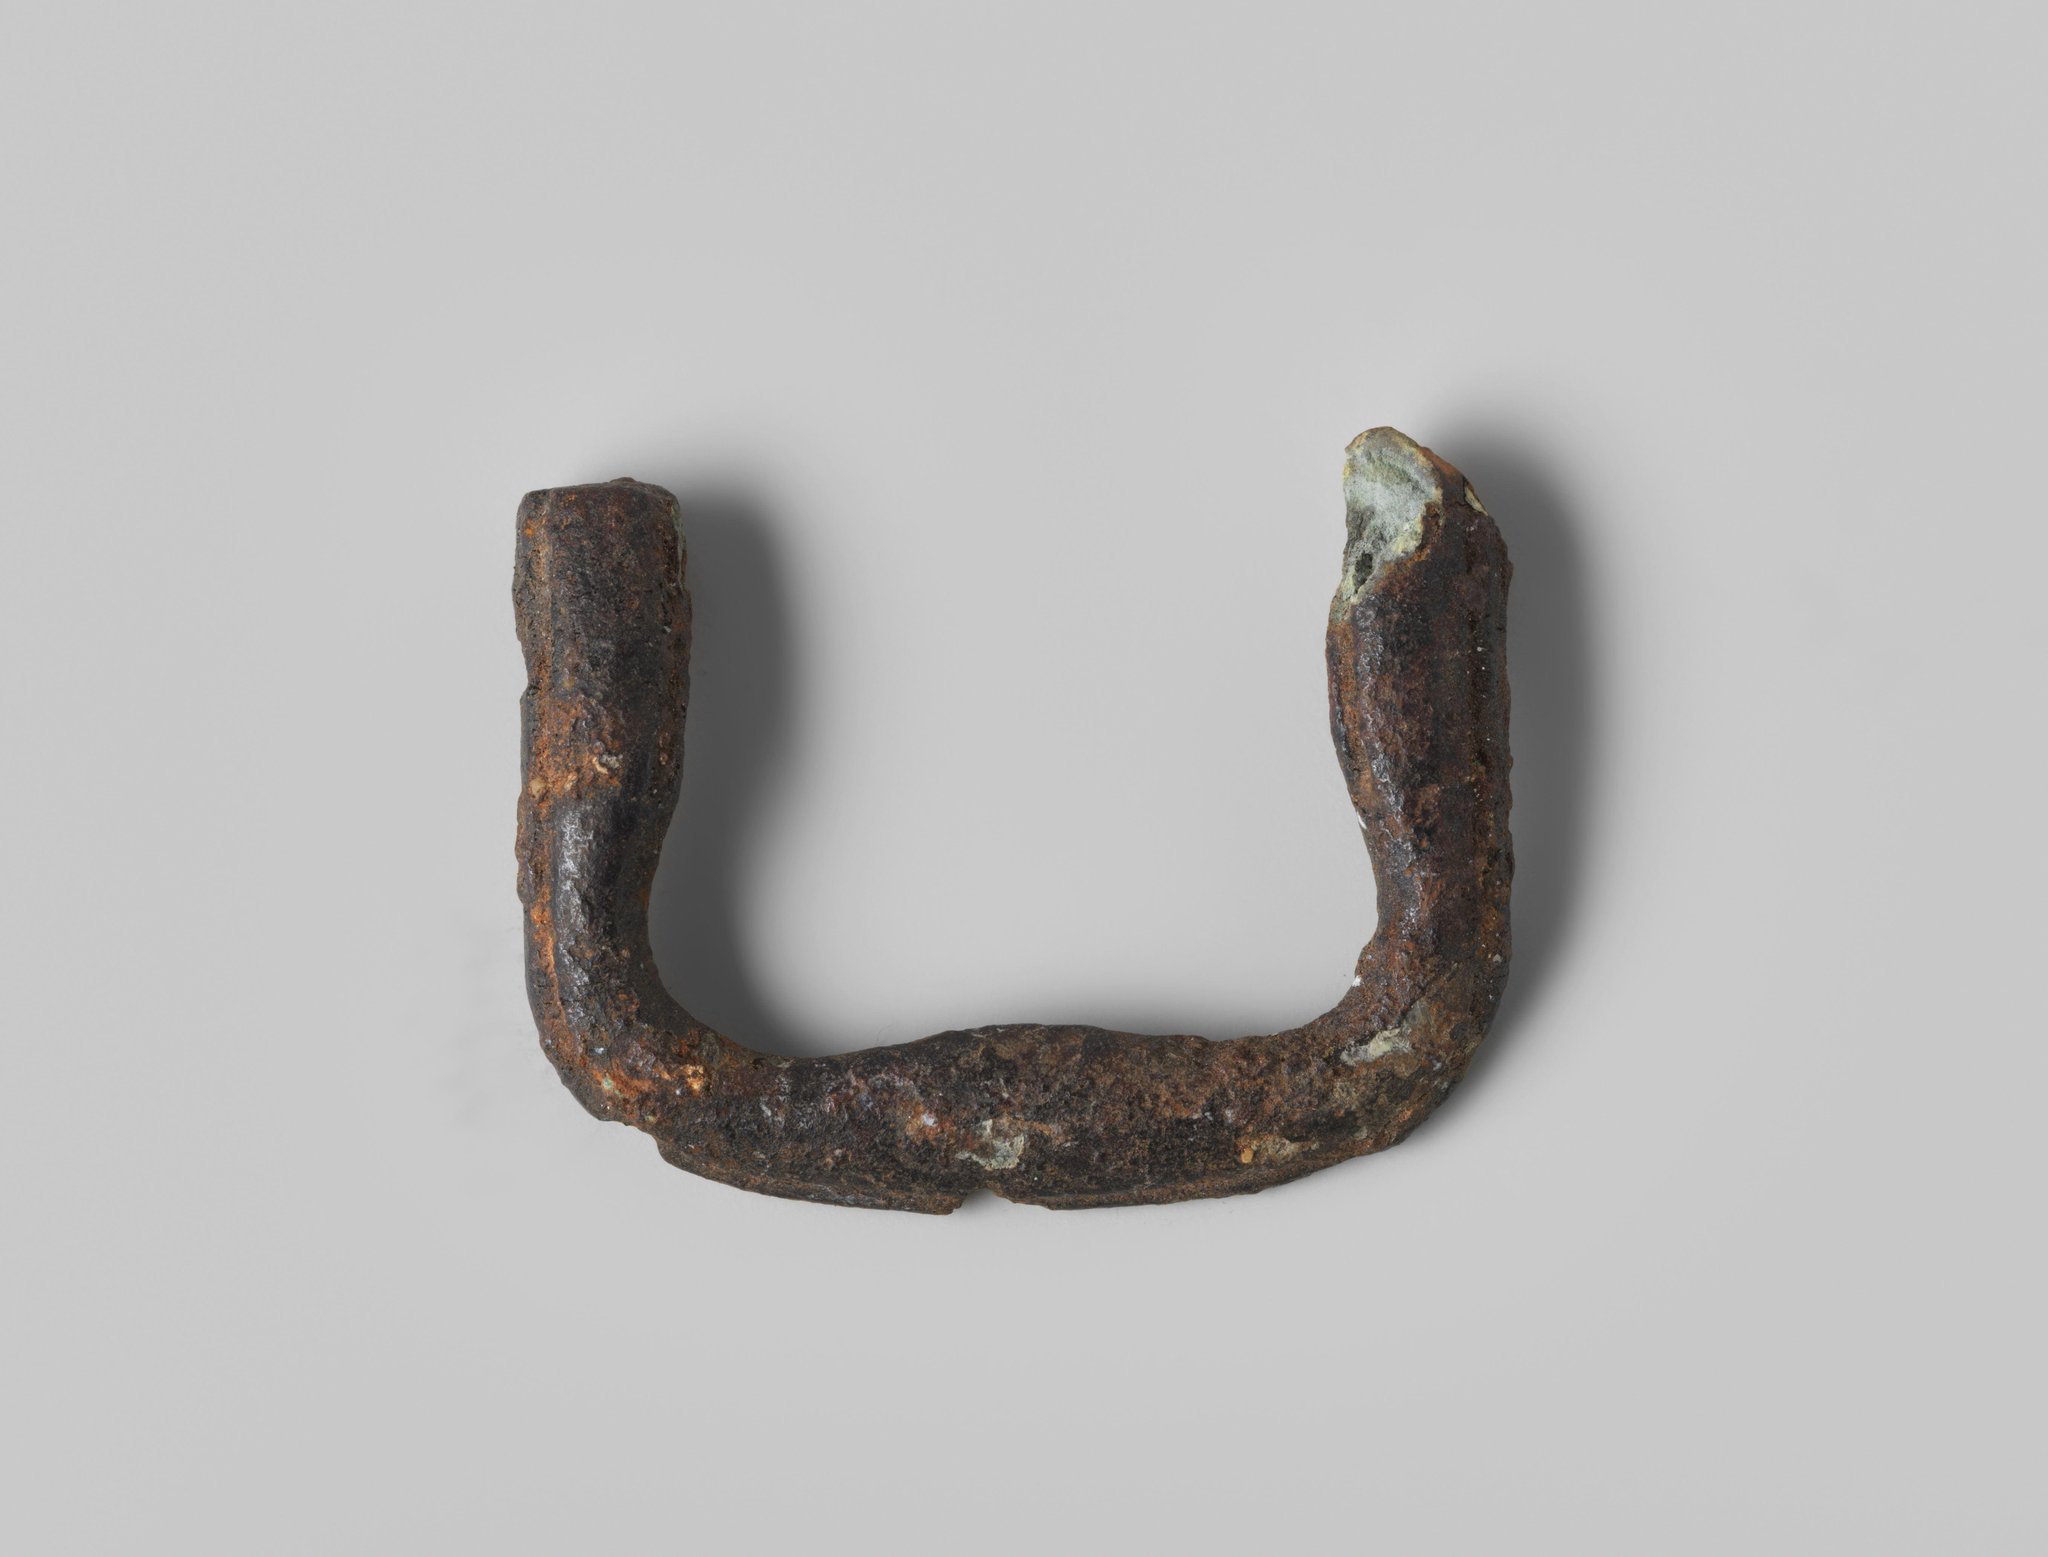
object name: shoe buckle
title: Fragment schoengesp uit het wrak van de Oost-Indiëvaarder Hollandia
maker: Anonymous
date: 1700-1743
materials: copper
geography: netherlands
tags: verenigde oostindische compagnie, hollandia (schip), annet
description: Buckle, chape buckle, shoe buckle; fragment of ring, id. NG 1980-27H2930.